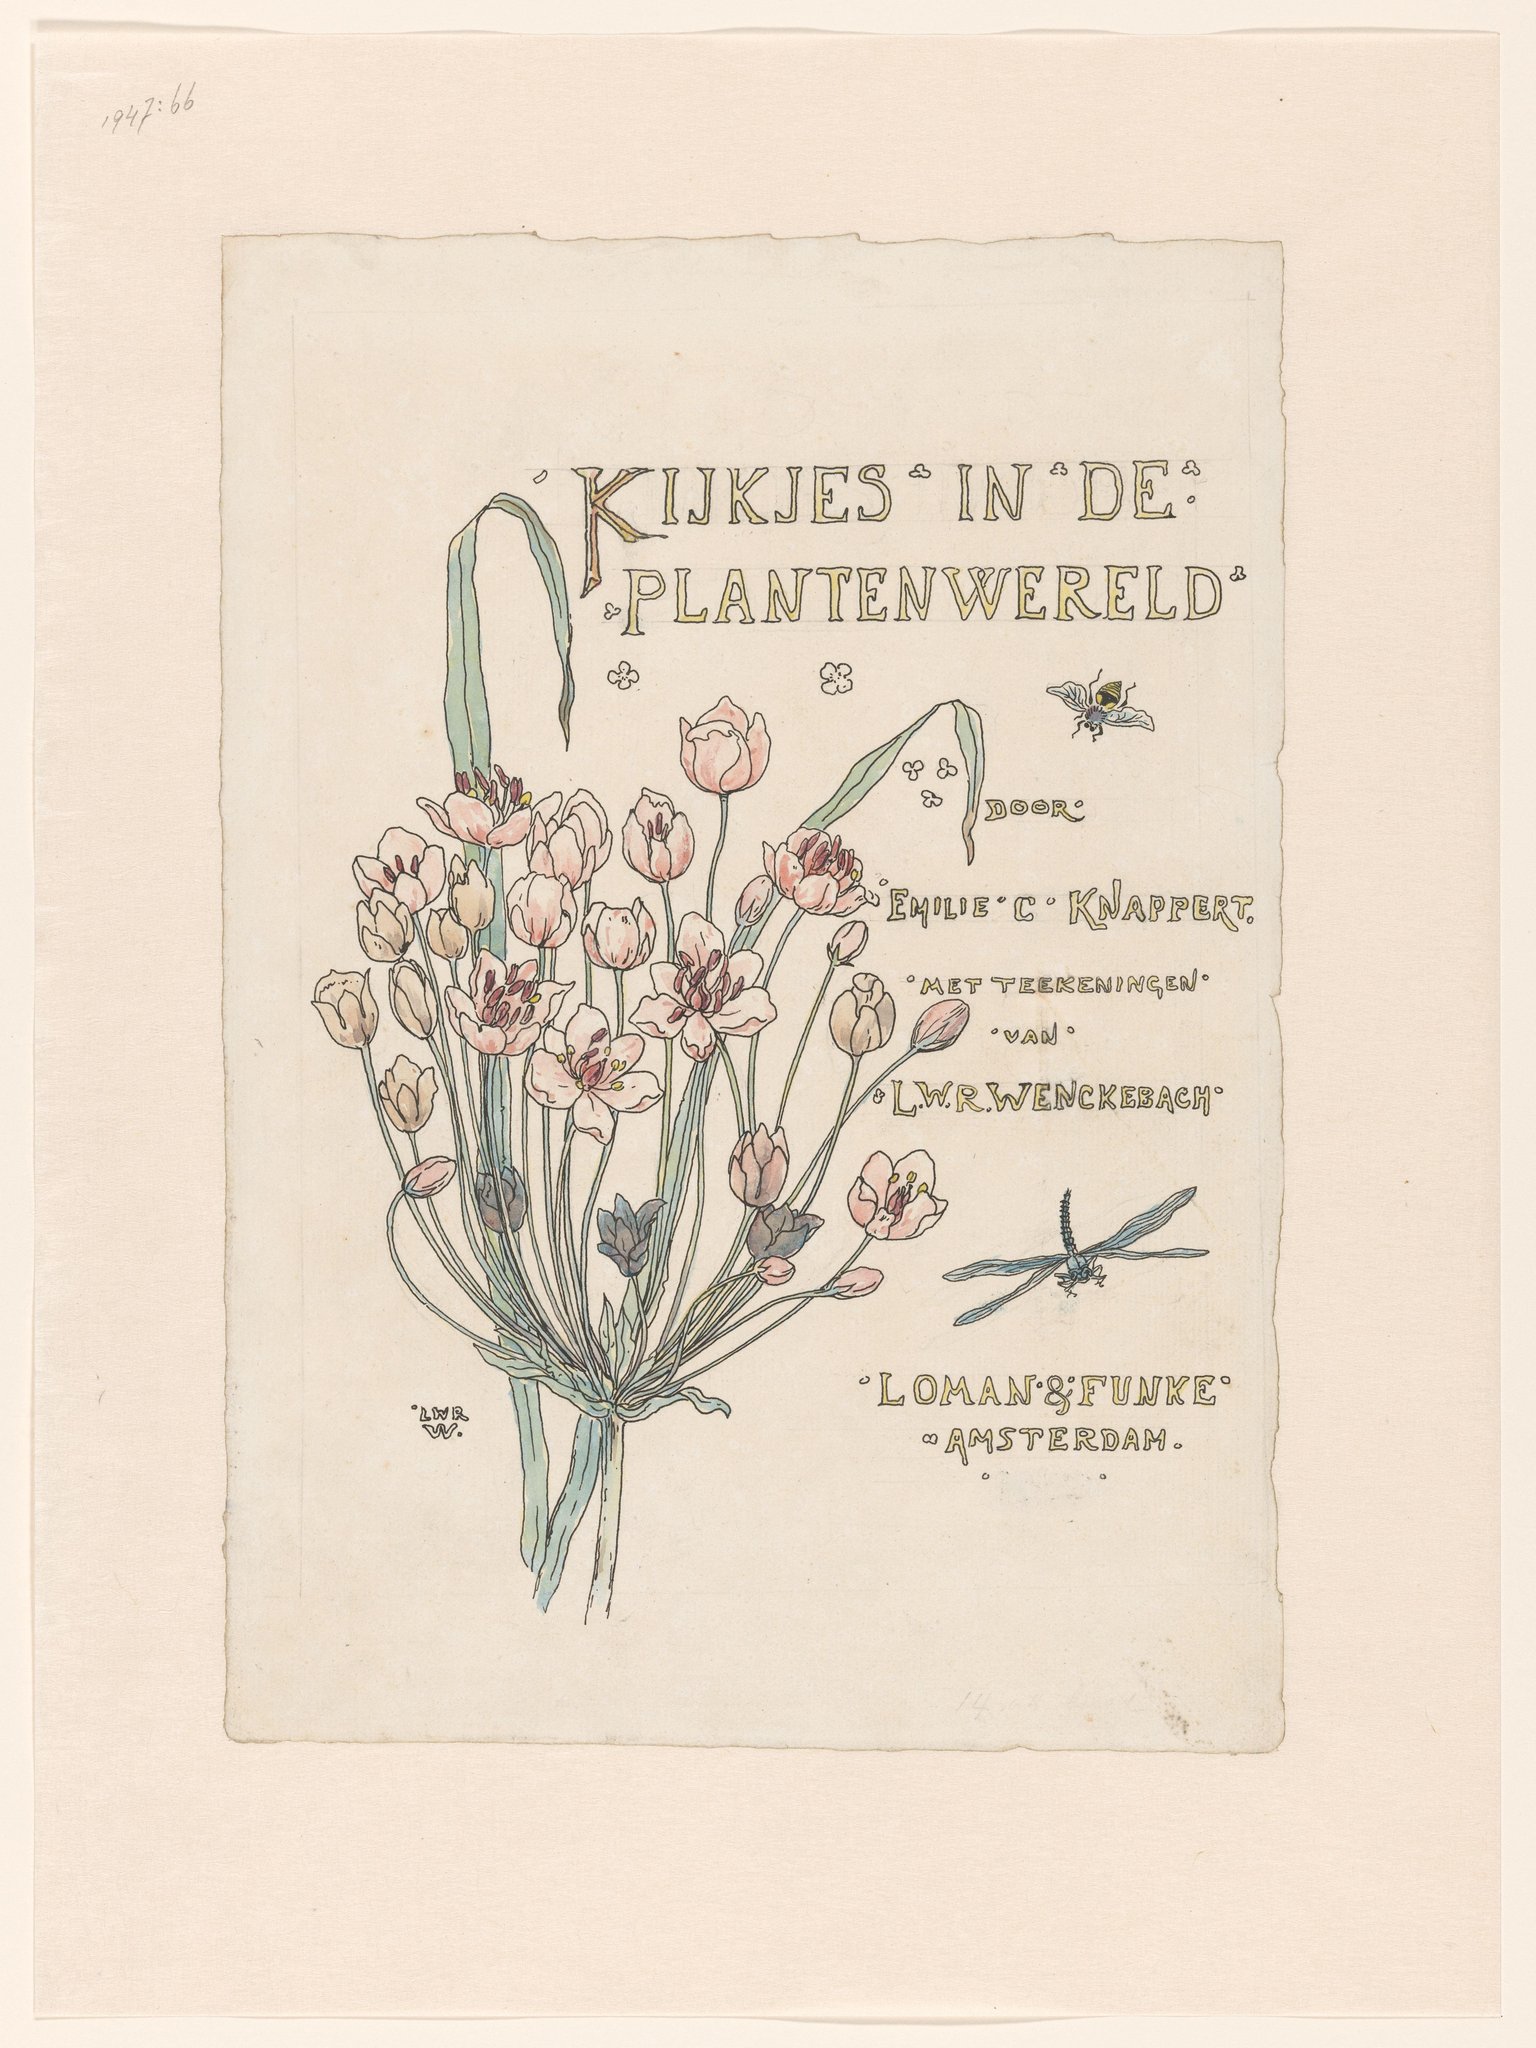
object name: design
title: Ontwerp voor een titelpagina voor: Emilie C. Knappert, Kijkjes in de plantenwereld, 1893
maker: willem wenckebach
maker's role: designer, draughtsman, painter, print maker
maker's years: 1860-1937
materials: ink, paper, pencil, watercolor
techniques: brush, pen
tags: flowers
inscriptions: :, collector's mark: Lugt 2228a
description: Ontwerp voor de titelpagina voor: Knappert, Emilie C. Kijkjes in de plantenwereld. Loman & Funke: Amsterdam, 1893.